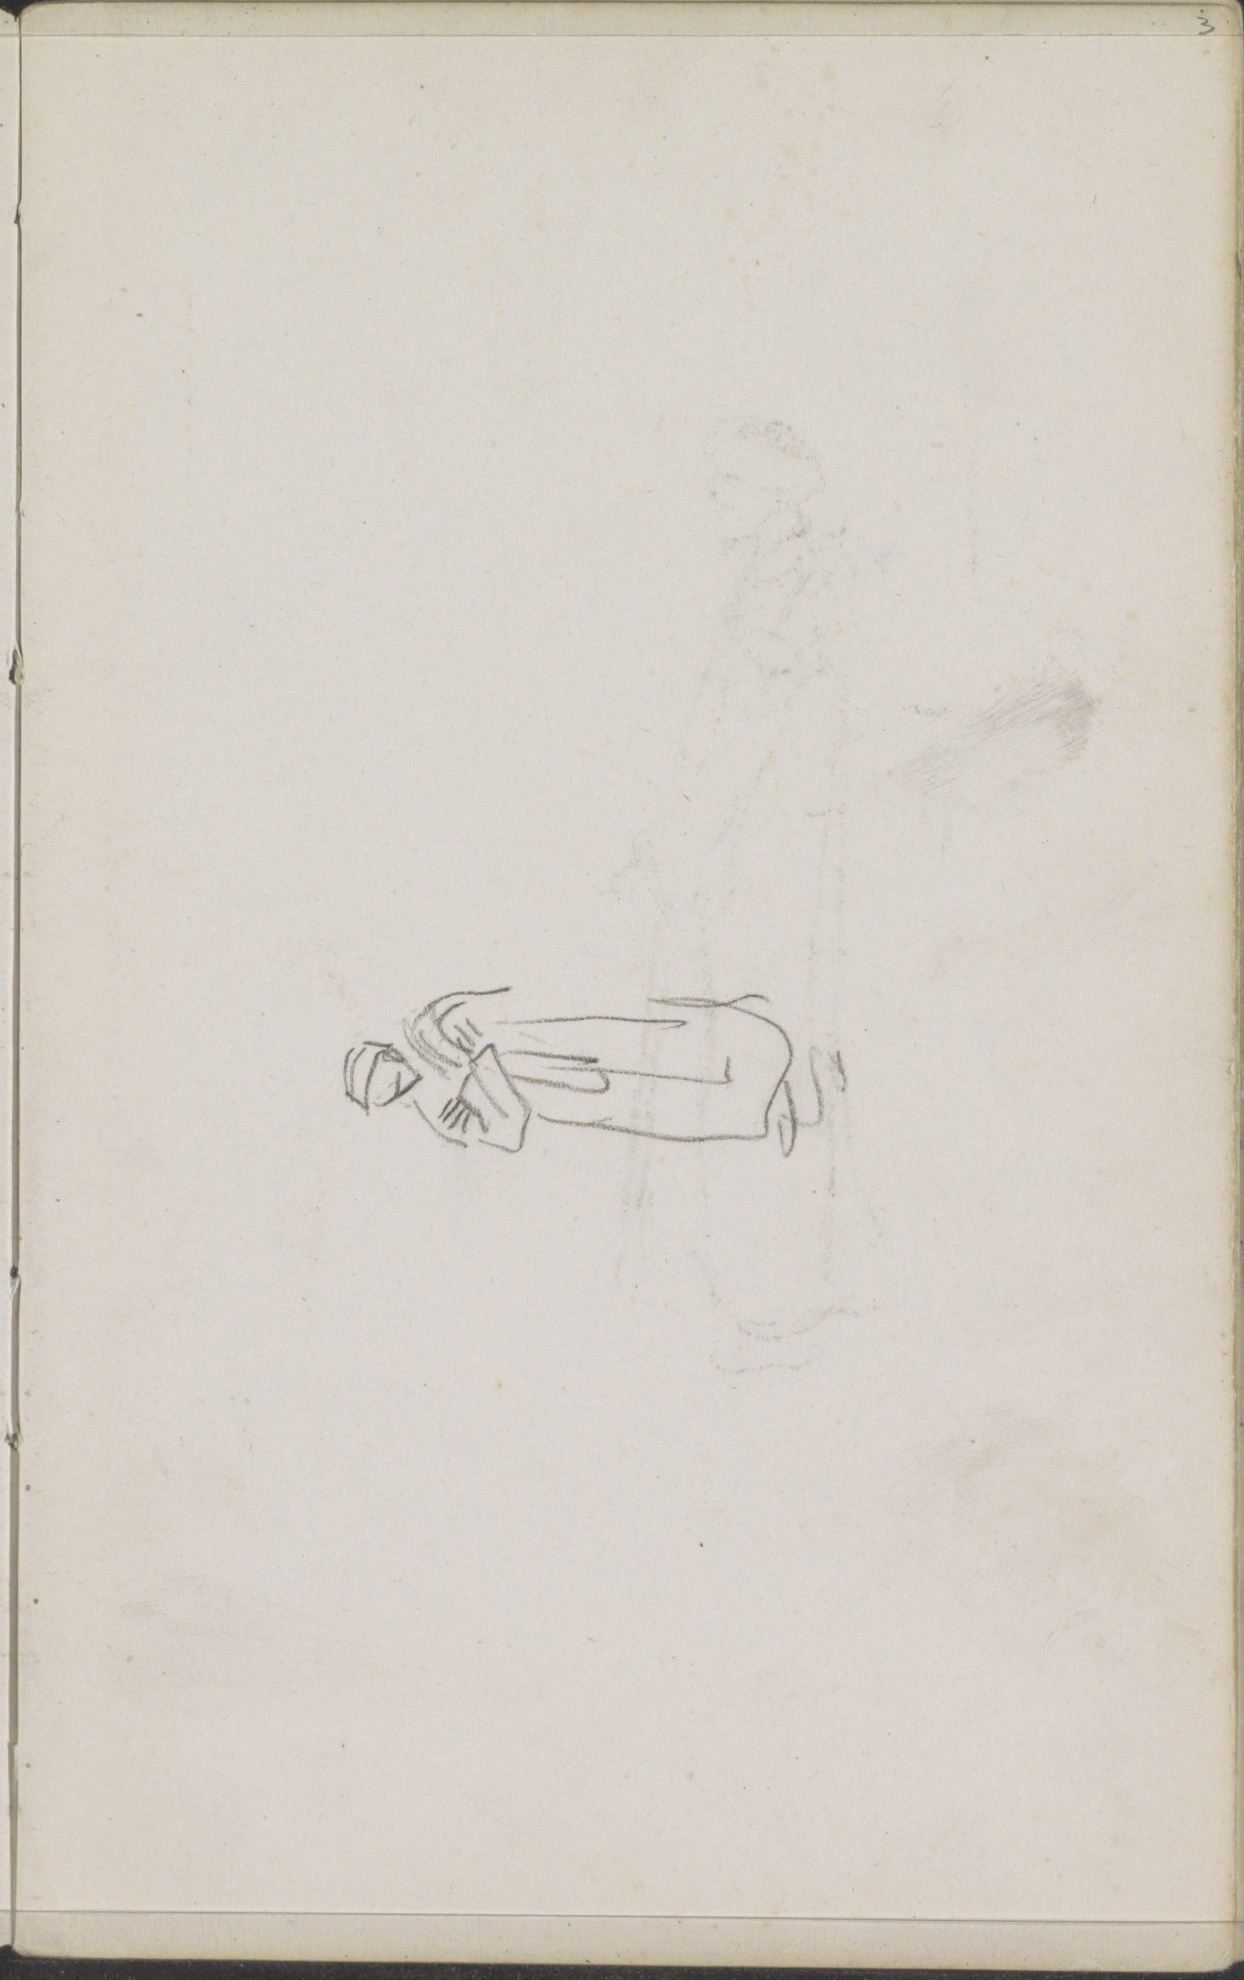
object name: sketchbook leaf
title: Figuur met gekruiste armen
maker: marius bauer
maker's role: draughtsman, print maker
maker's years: 1867-1932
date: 1896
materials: chalk, paper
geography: istanbul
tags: asiatic races and peoples, standing figure, arms crossed over the breast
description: Pagina 3 uit een schetsboek met 53 bladen.